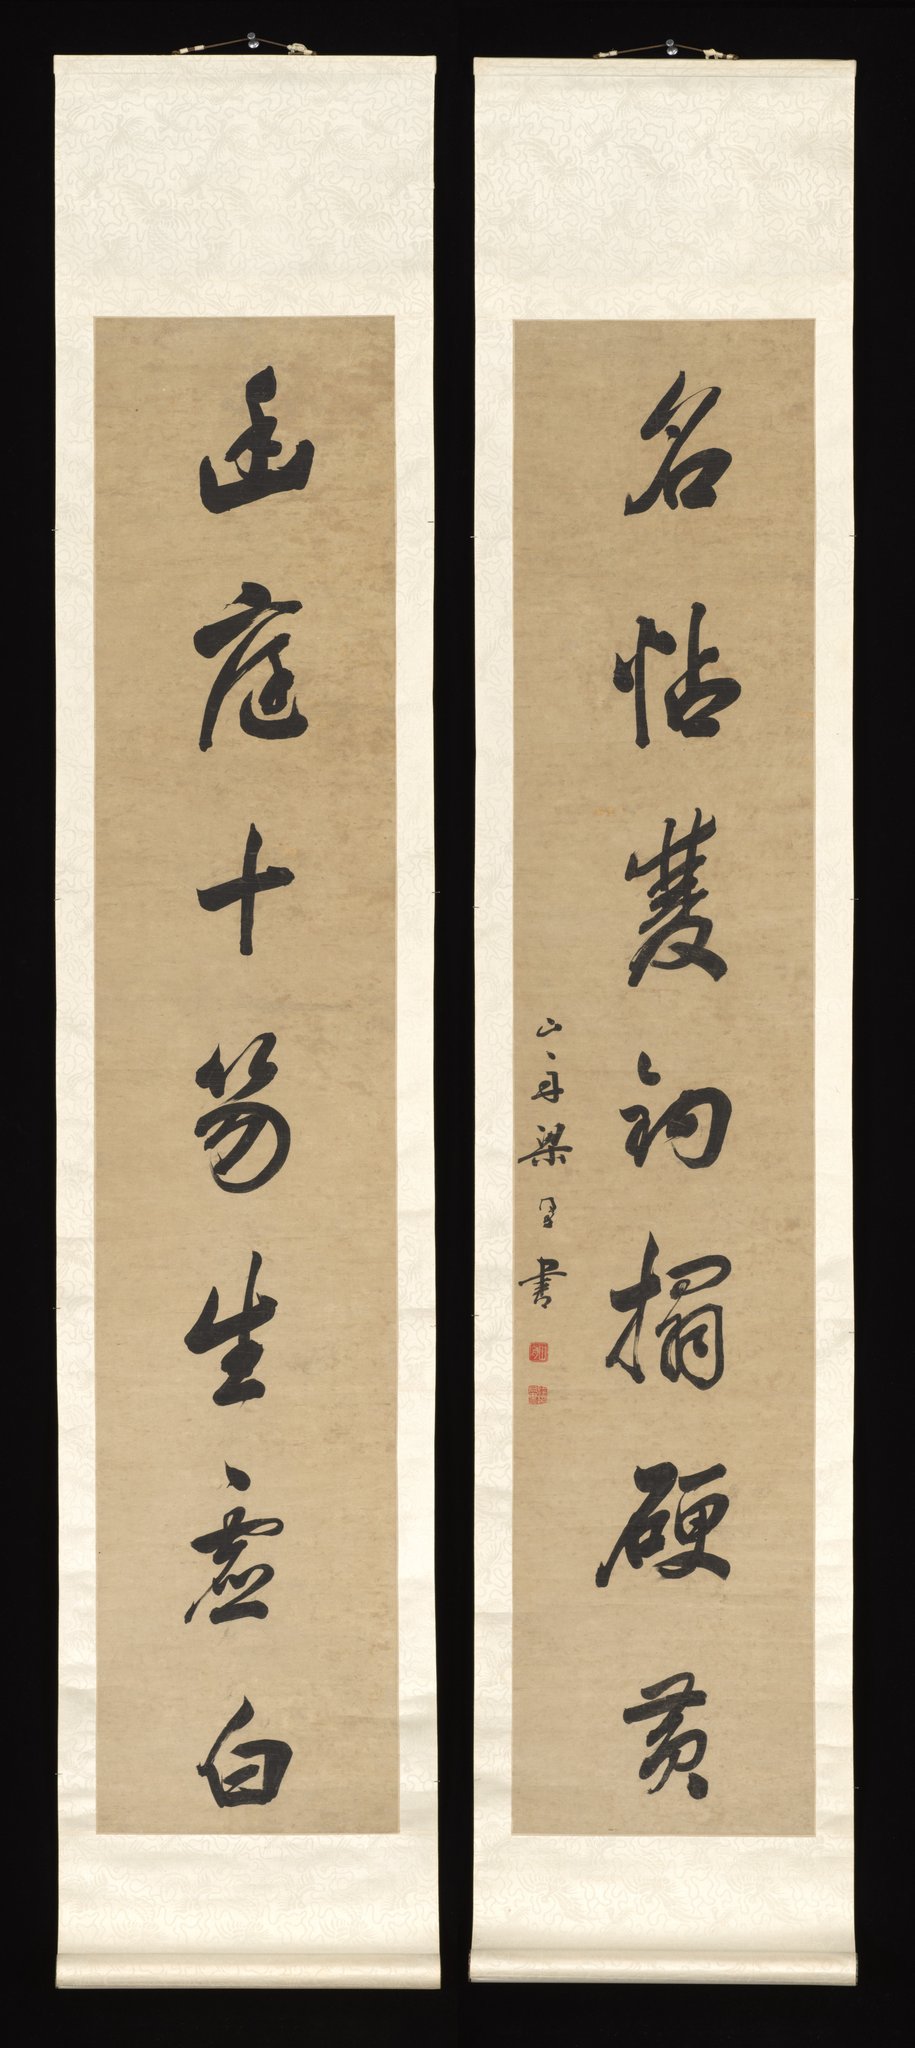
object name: hanging scroll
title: Running-script Calligraphic Couplet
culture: chinese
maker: liang tongshu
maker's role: artist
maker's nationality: chinese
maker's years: 1723-1815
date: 1701-1800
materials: ink, paper